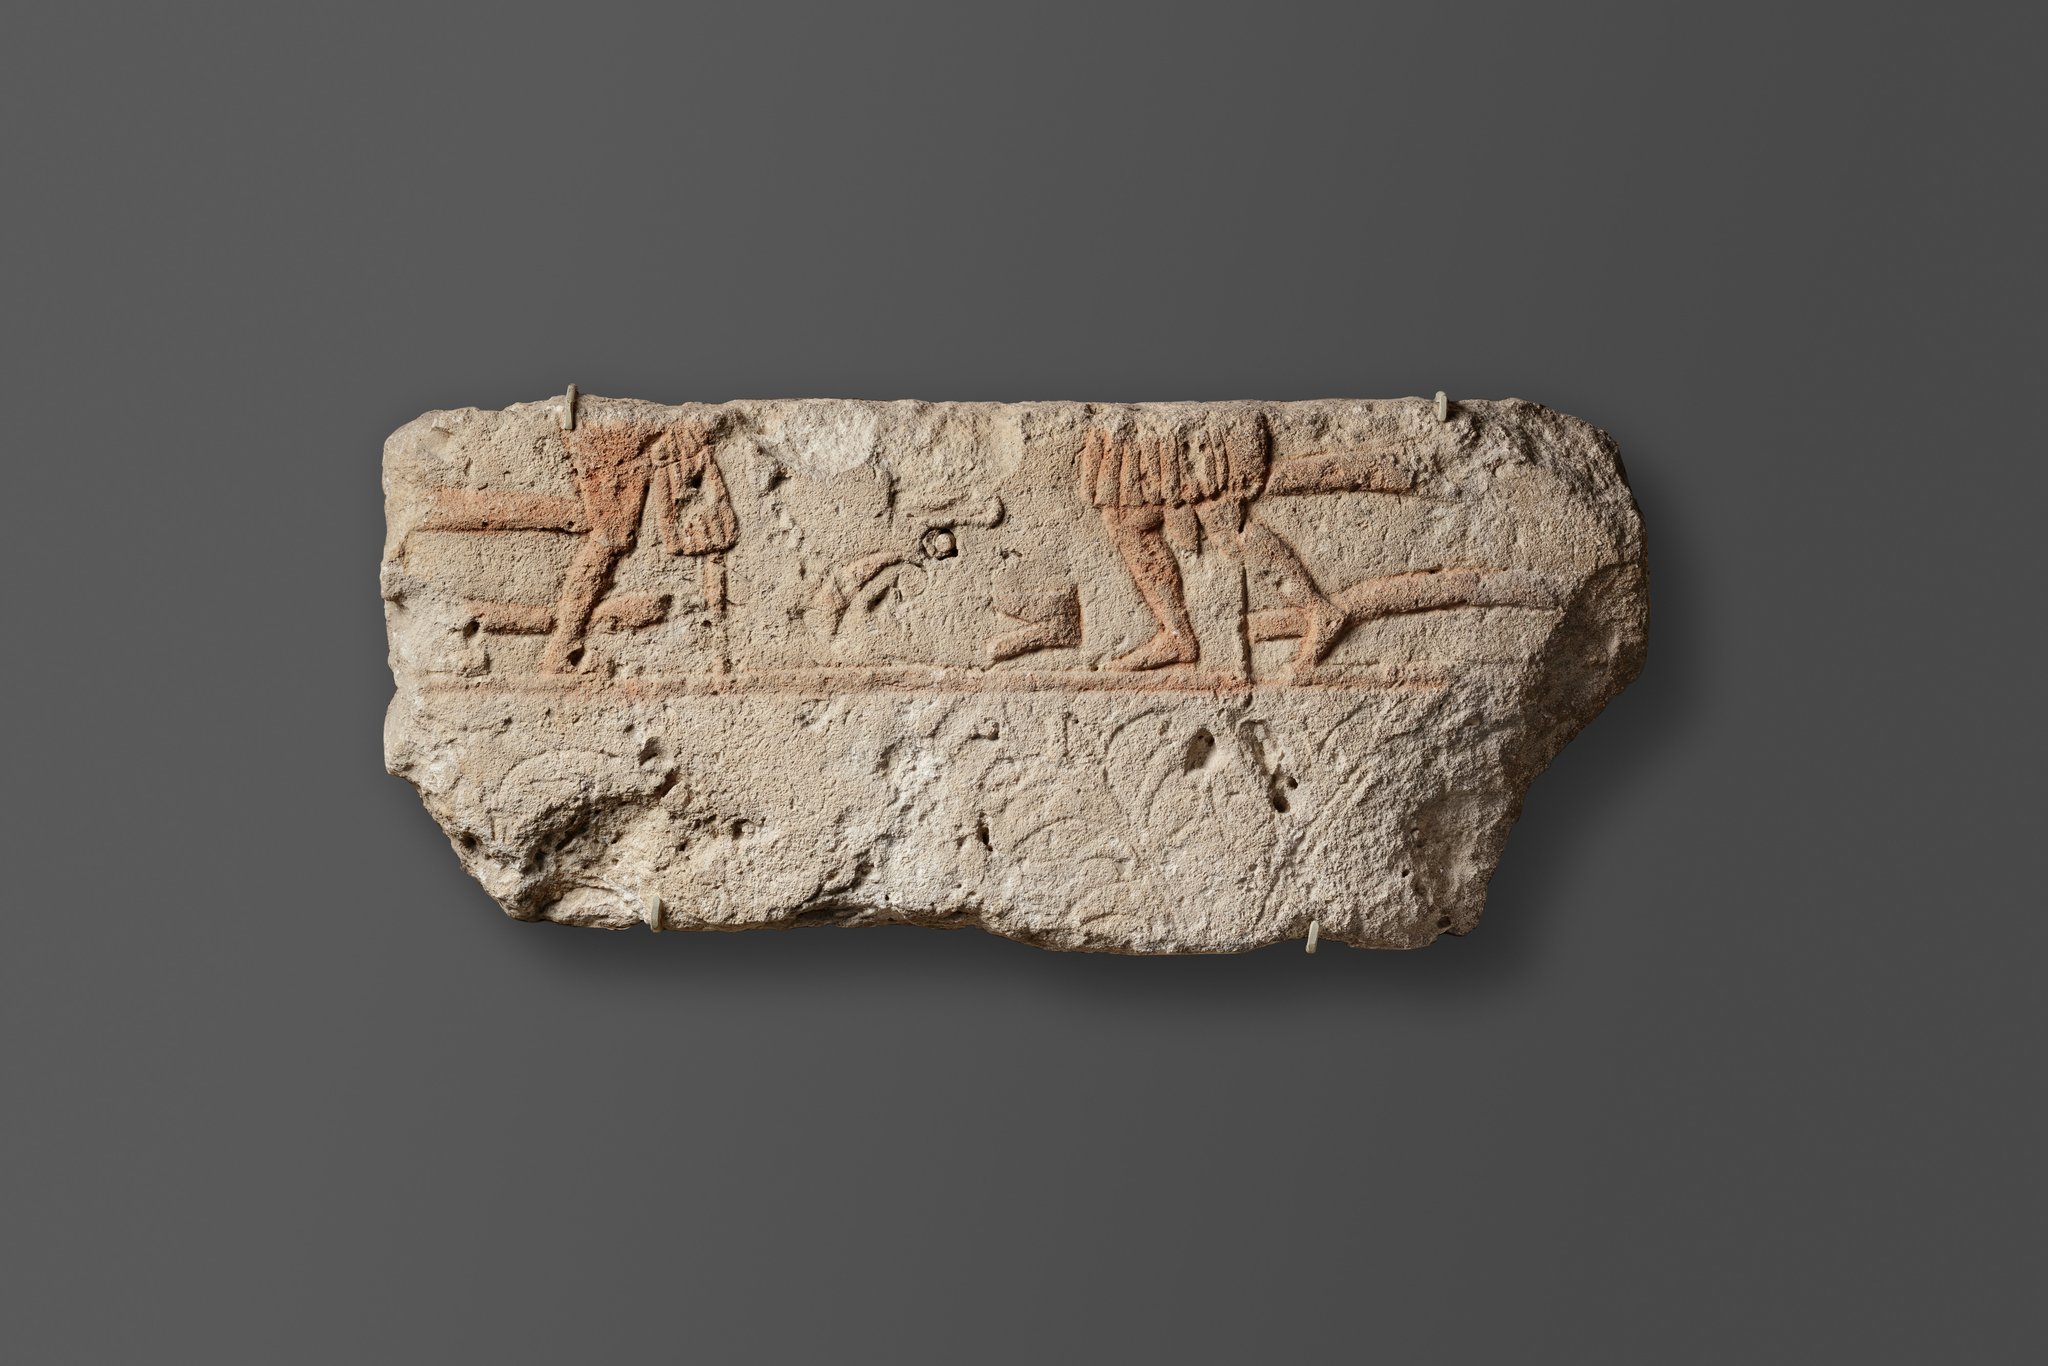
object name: talatat, construction scene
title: Relief with a construction scene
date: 1353-1336 BCE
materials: limestone, paint